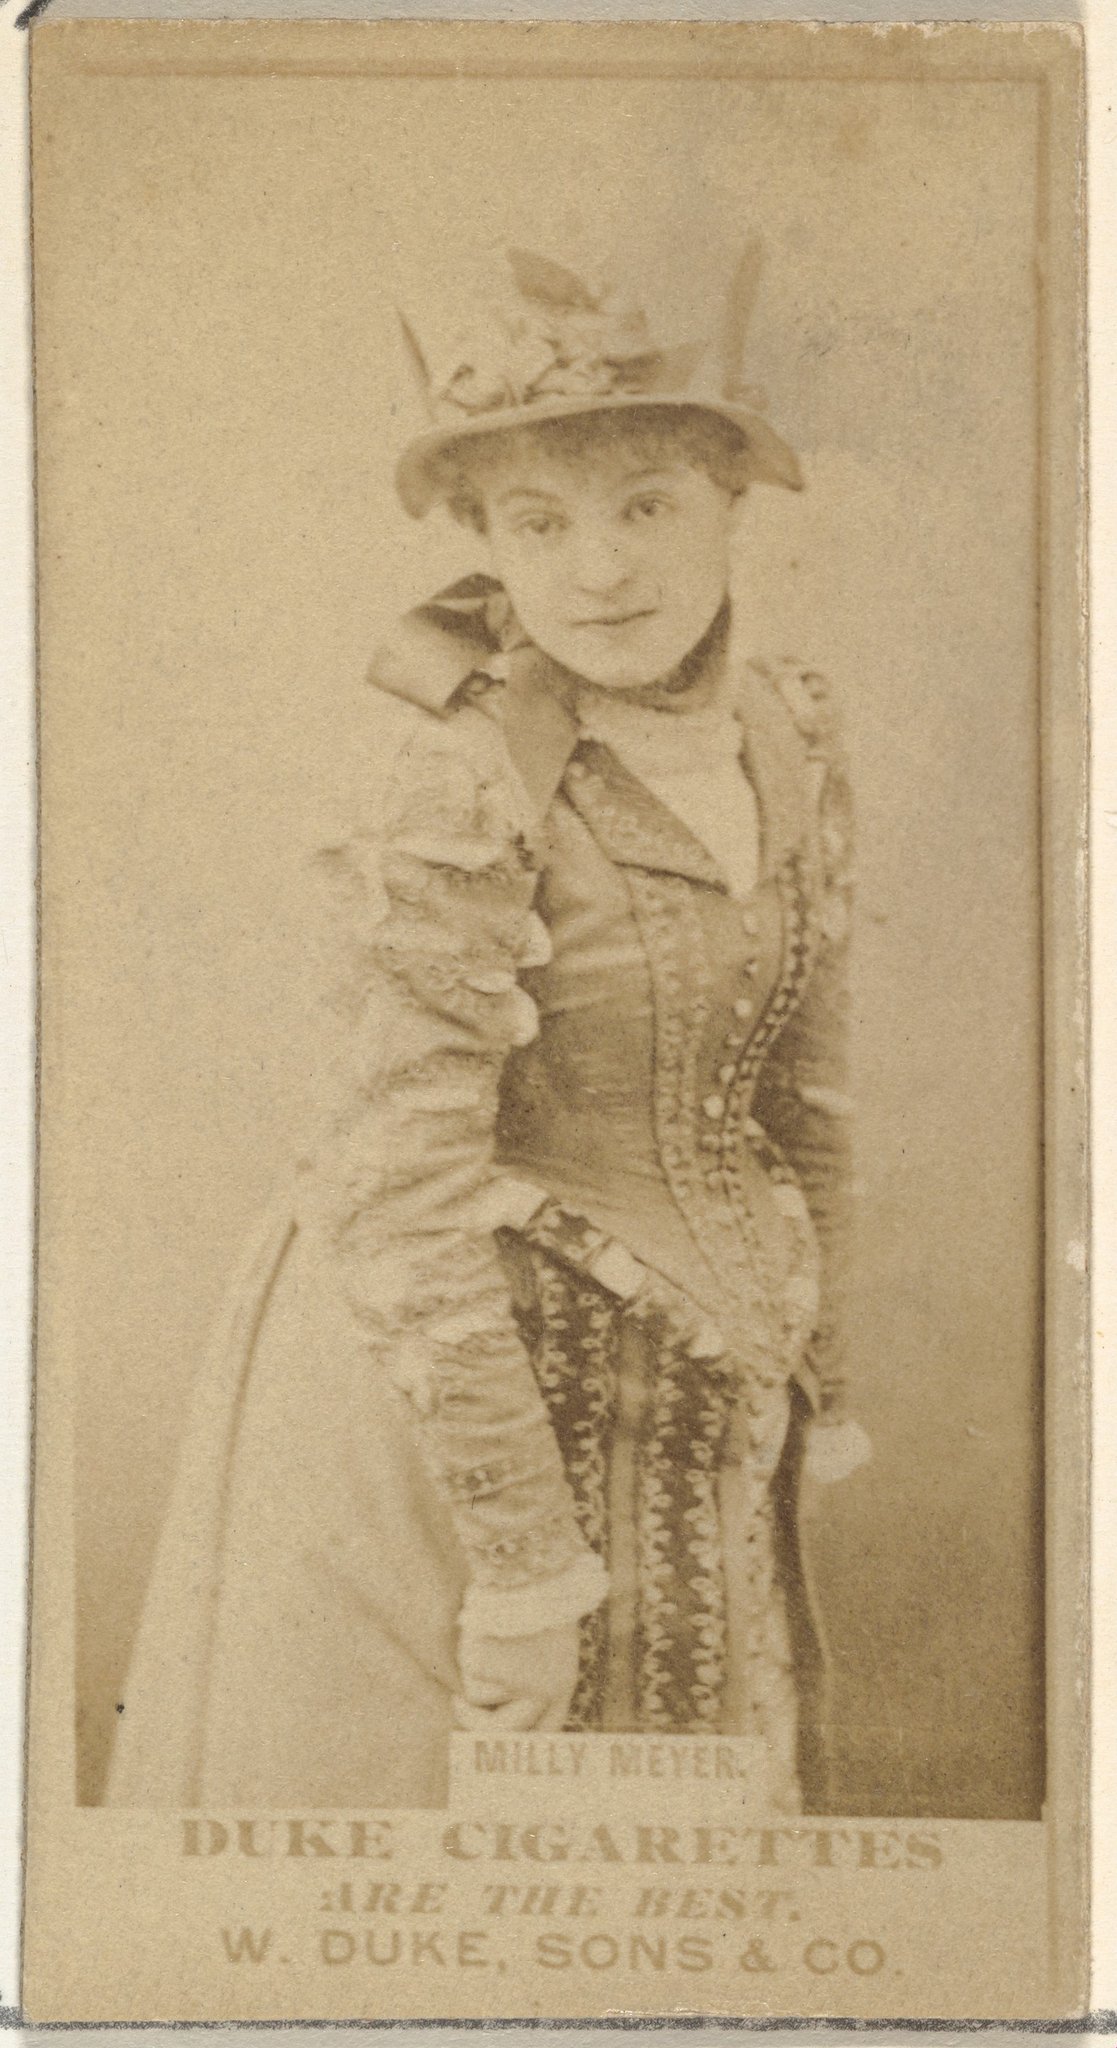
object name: photograph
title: Milly Meyer, from the Actors and Actresses series (N145-7) issued by Duke Sons & Co. to promote Duke Cigarettes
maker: w. duke, sons & co.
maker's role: publisher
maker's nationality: american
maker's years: 1870-1920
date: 1880-1889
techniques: albumen silver print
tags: portraits,women,actresses